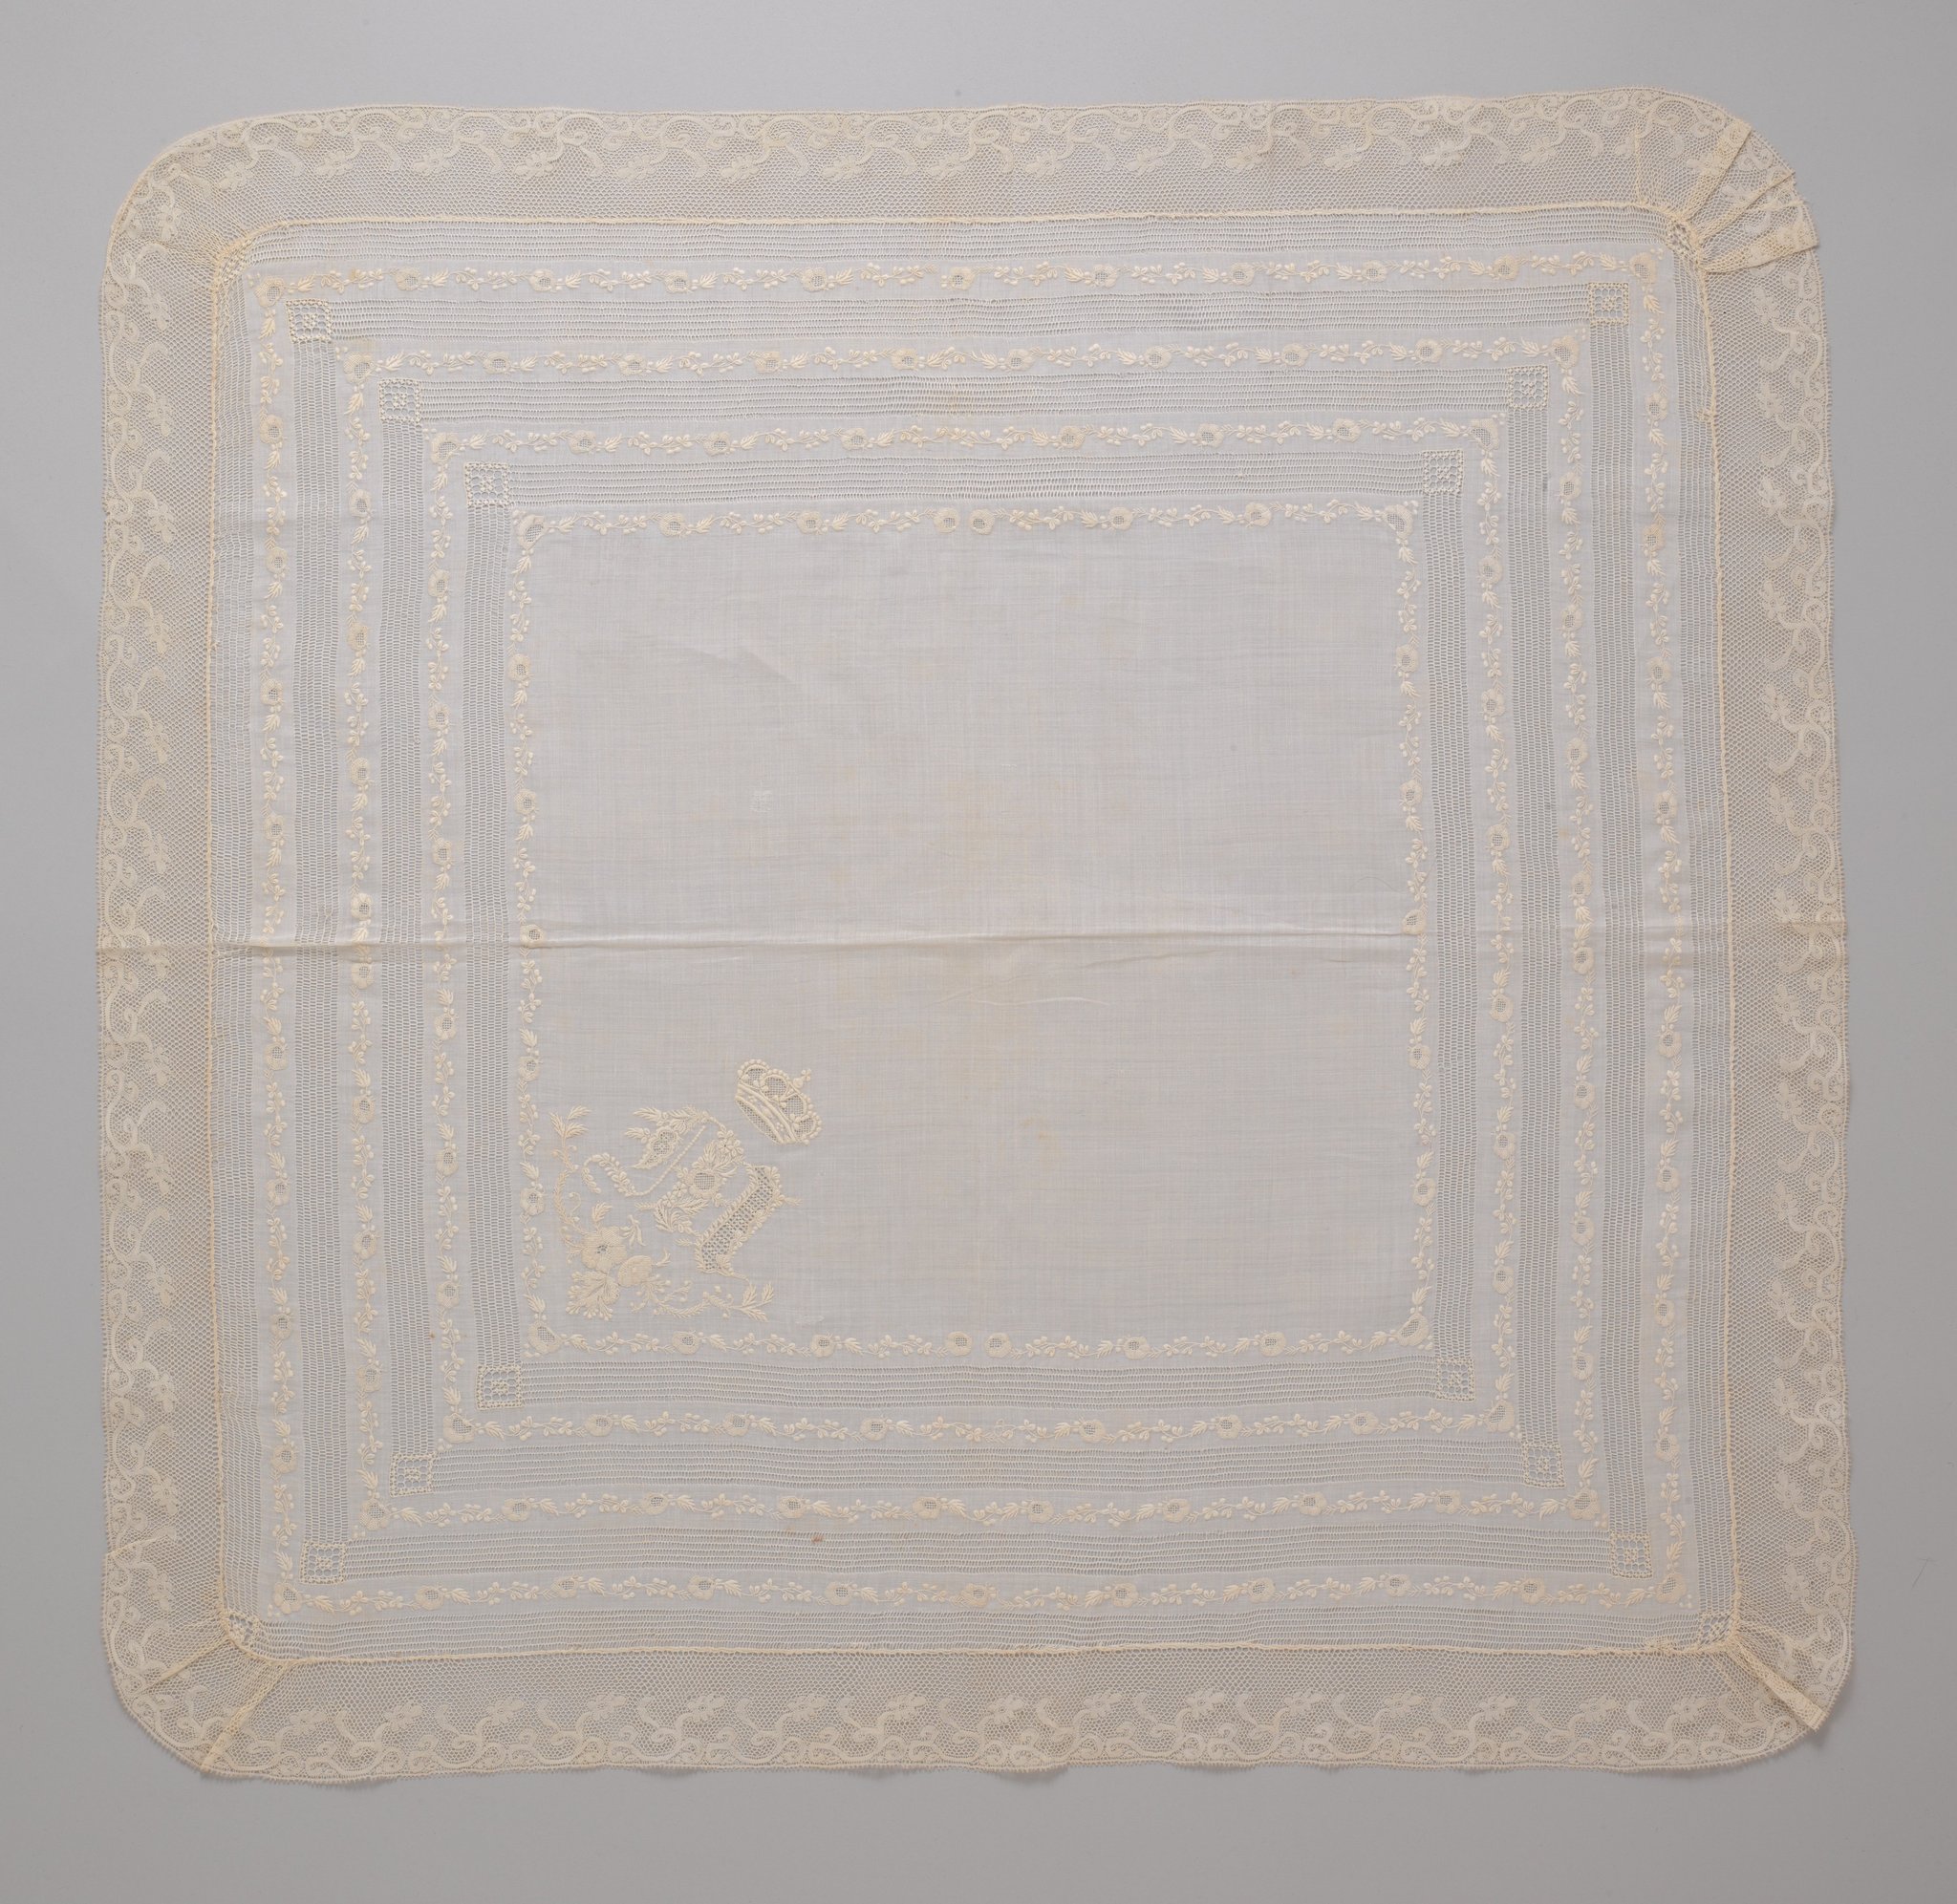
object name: handkerchief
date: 1840-1880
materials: linen, silk